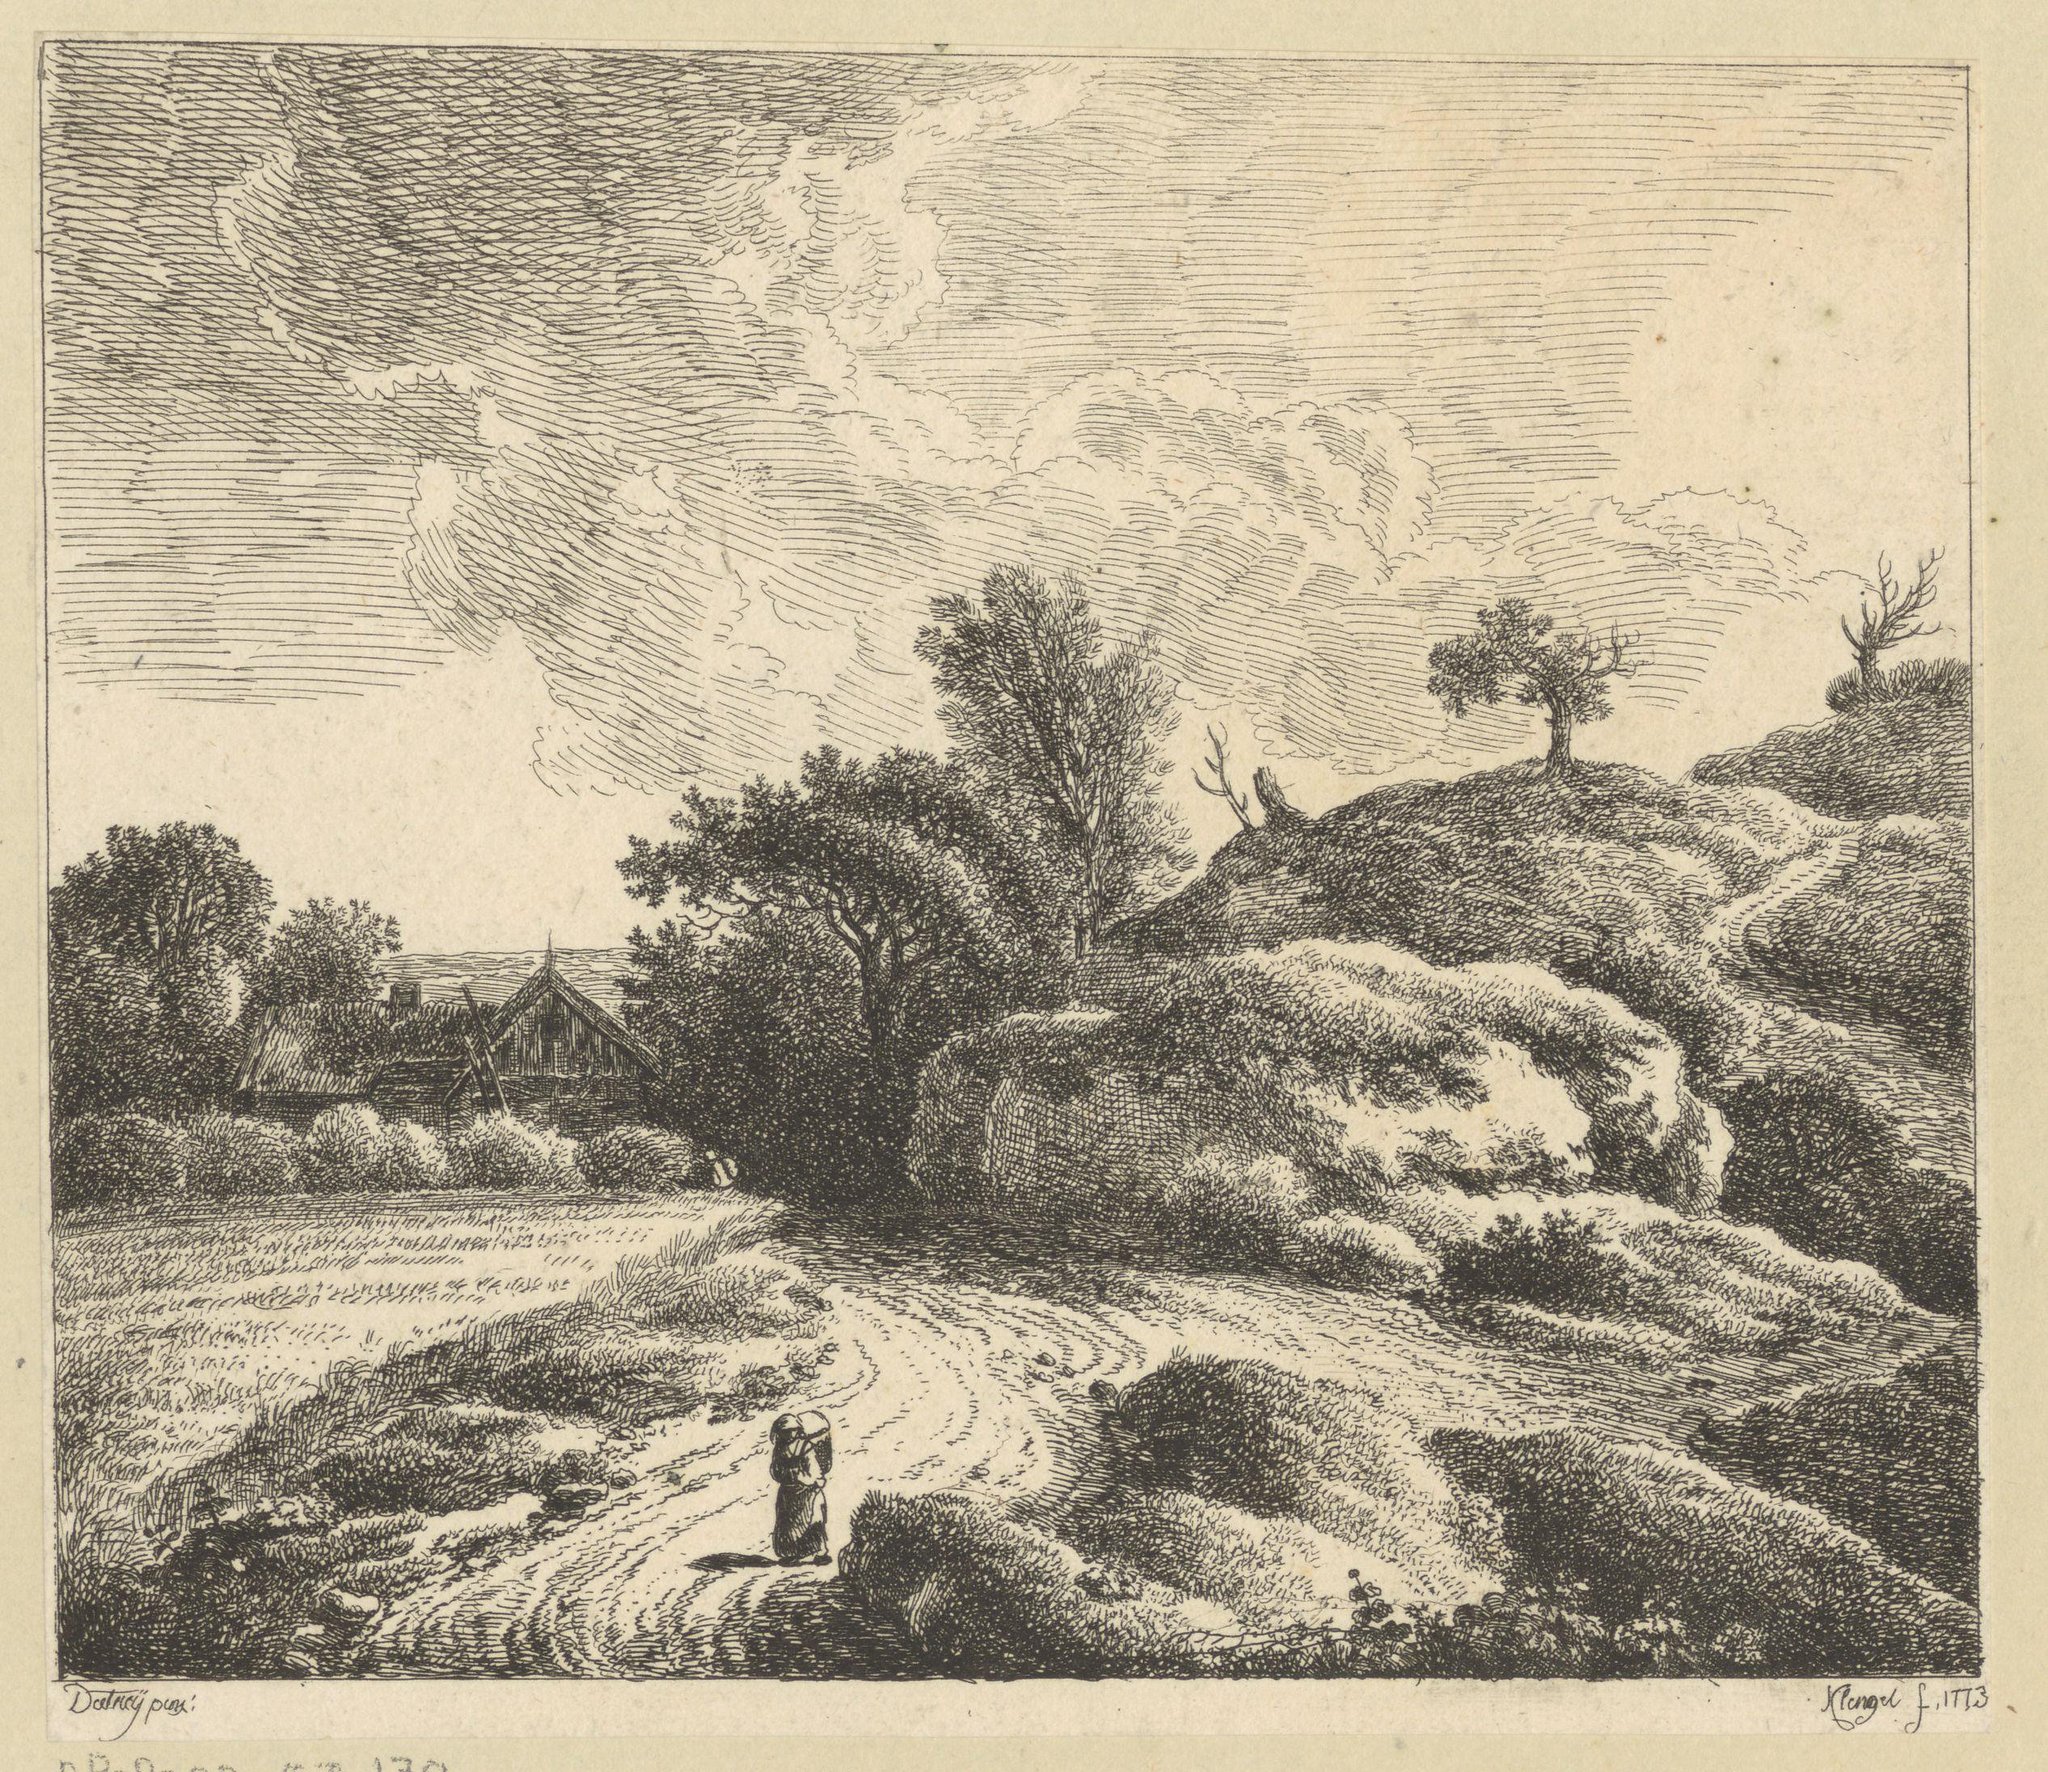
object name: print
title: Landschap met een reiziger met bepakking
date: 1773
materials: paper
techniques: etching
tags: low hill country, farm (building)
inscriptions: collector's mark: Lugt 240